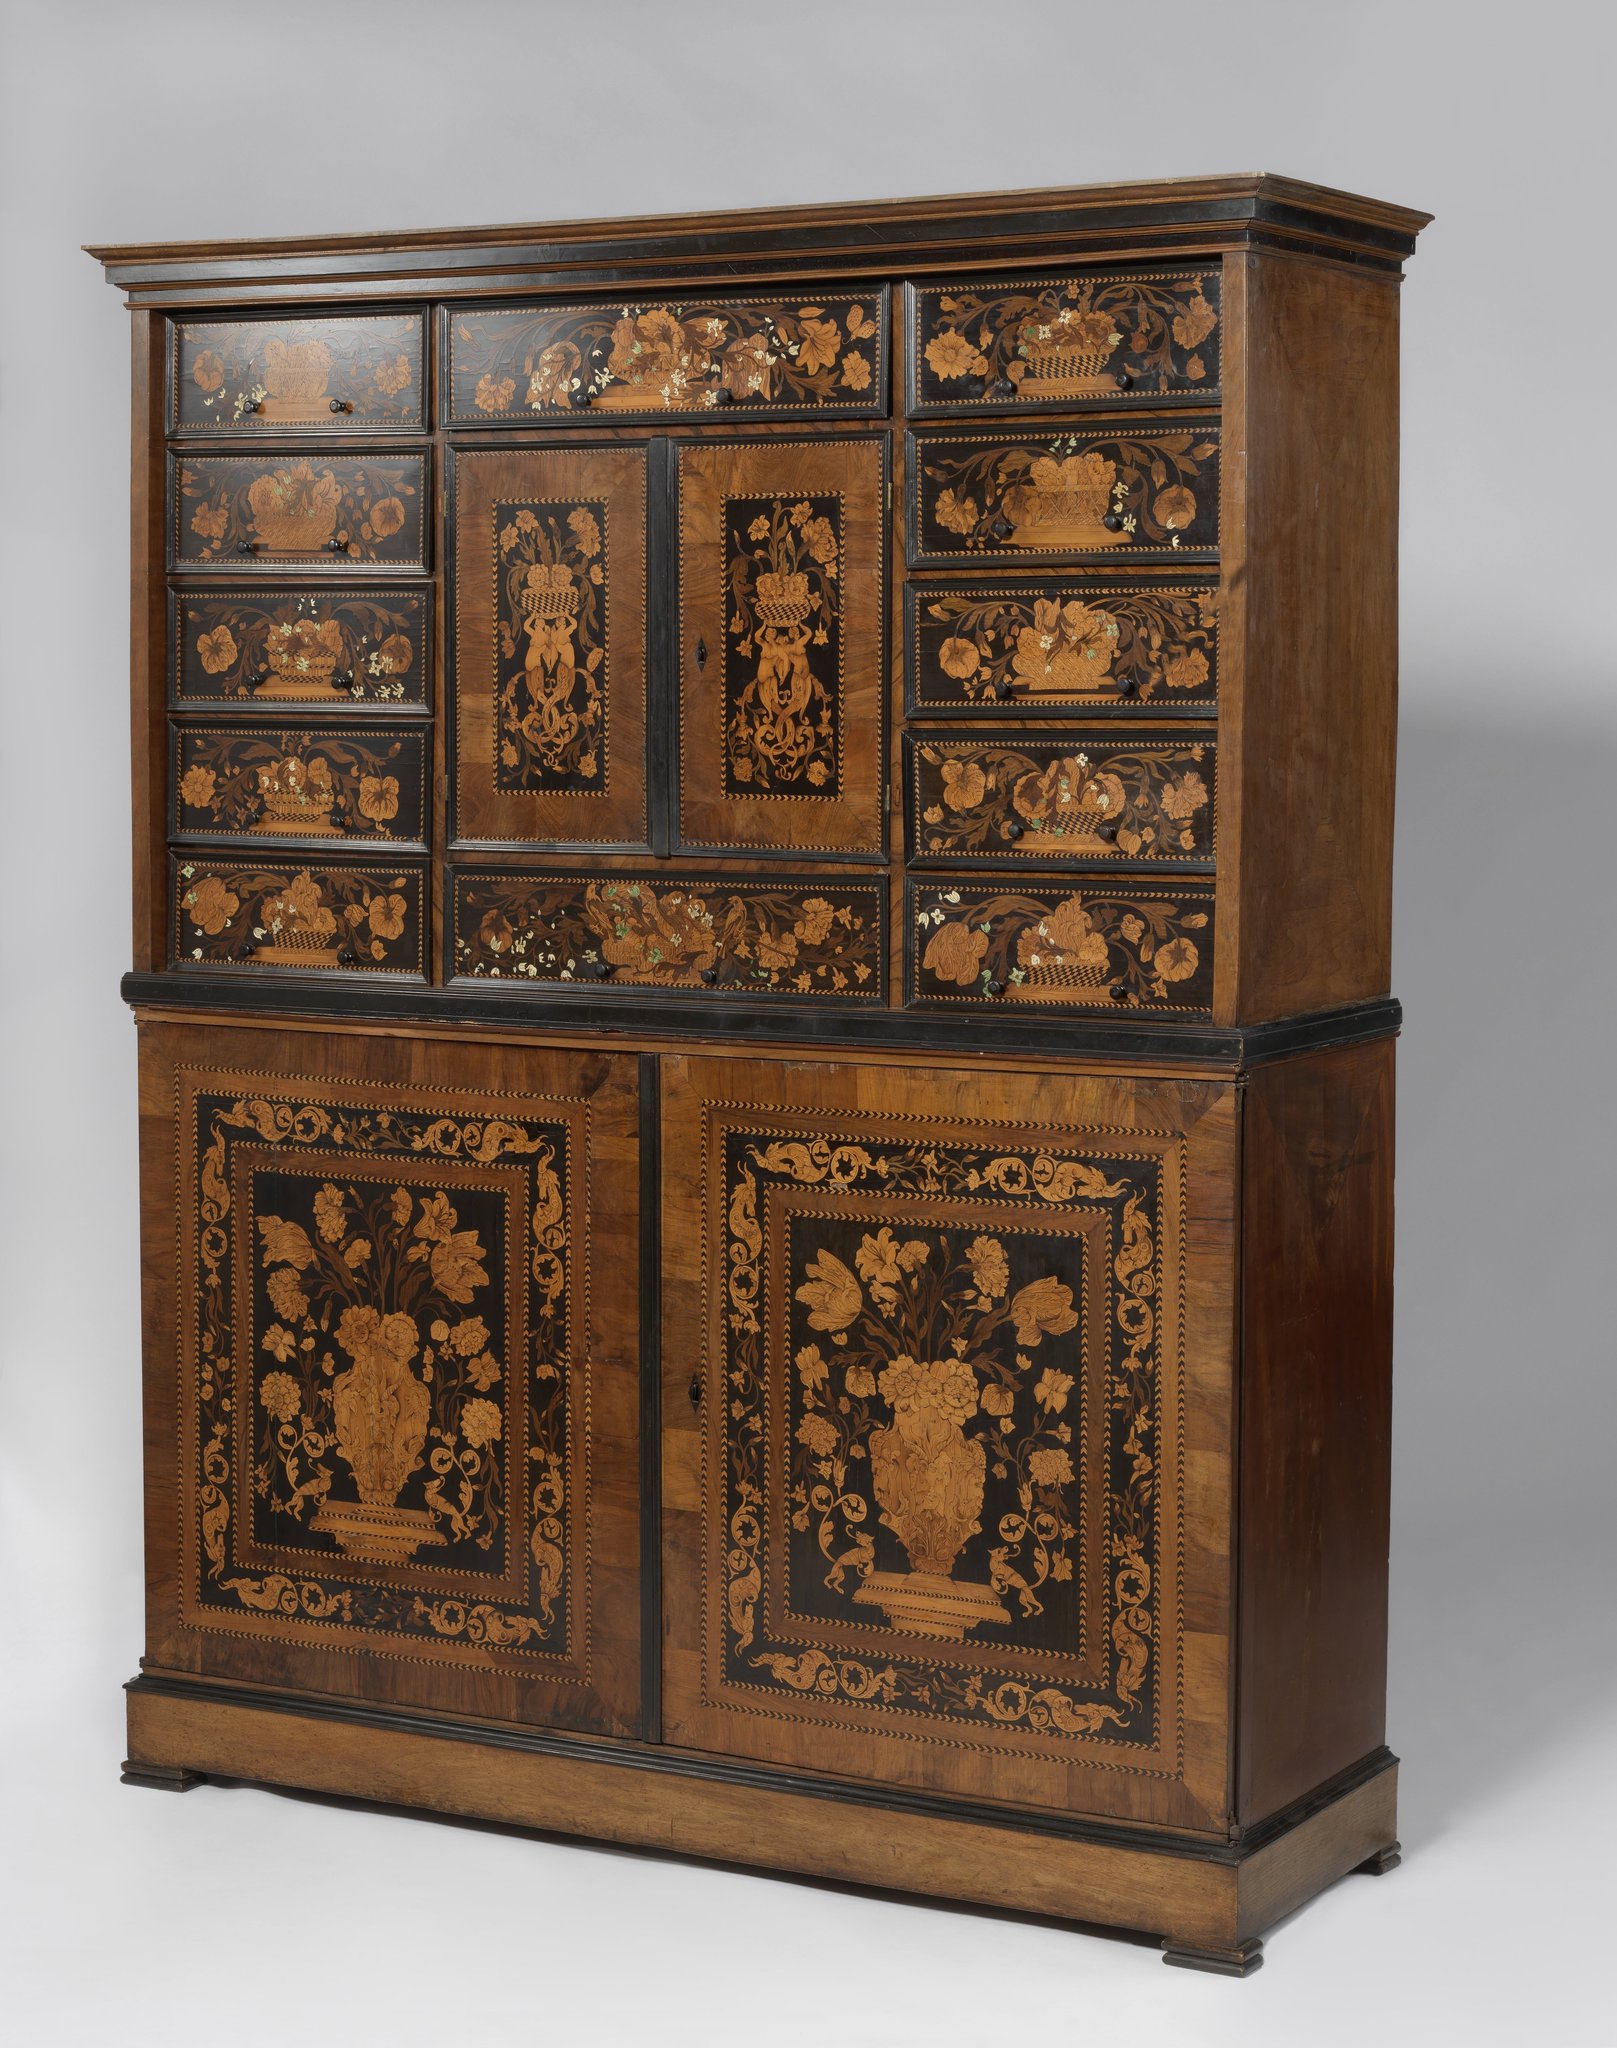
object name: furniture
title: Kast met marqueterie van bloemen, vogels, vlinders, meerminnen en tritons met kinkhorens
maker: Anonymous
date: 1675-1700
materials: wood, ivory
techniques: marquetry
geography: southern netherlands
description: Kast belijmd met notenhout en versierd met marketerie van noten-, satijn-, palissander-, ebbenhout en ivoor op een grenenhouten kern. Het meubel is verdeeld in een onder- en bovenkast. De bovenkast vertoont twee deurtjes, ter weerszijden waarvan vijf laden, en boven en onder één. De onderkast heeft twee frontdeuren. De laden en deuren zijn gemarketteerd met bloemen, vogels, vlinders, meerminnen en tritons met klinkhorens. In de bovenste hoorn in ivoor de letters FVG en links in notenhout het woord GRABANT.